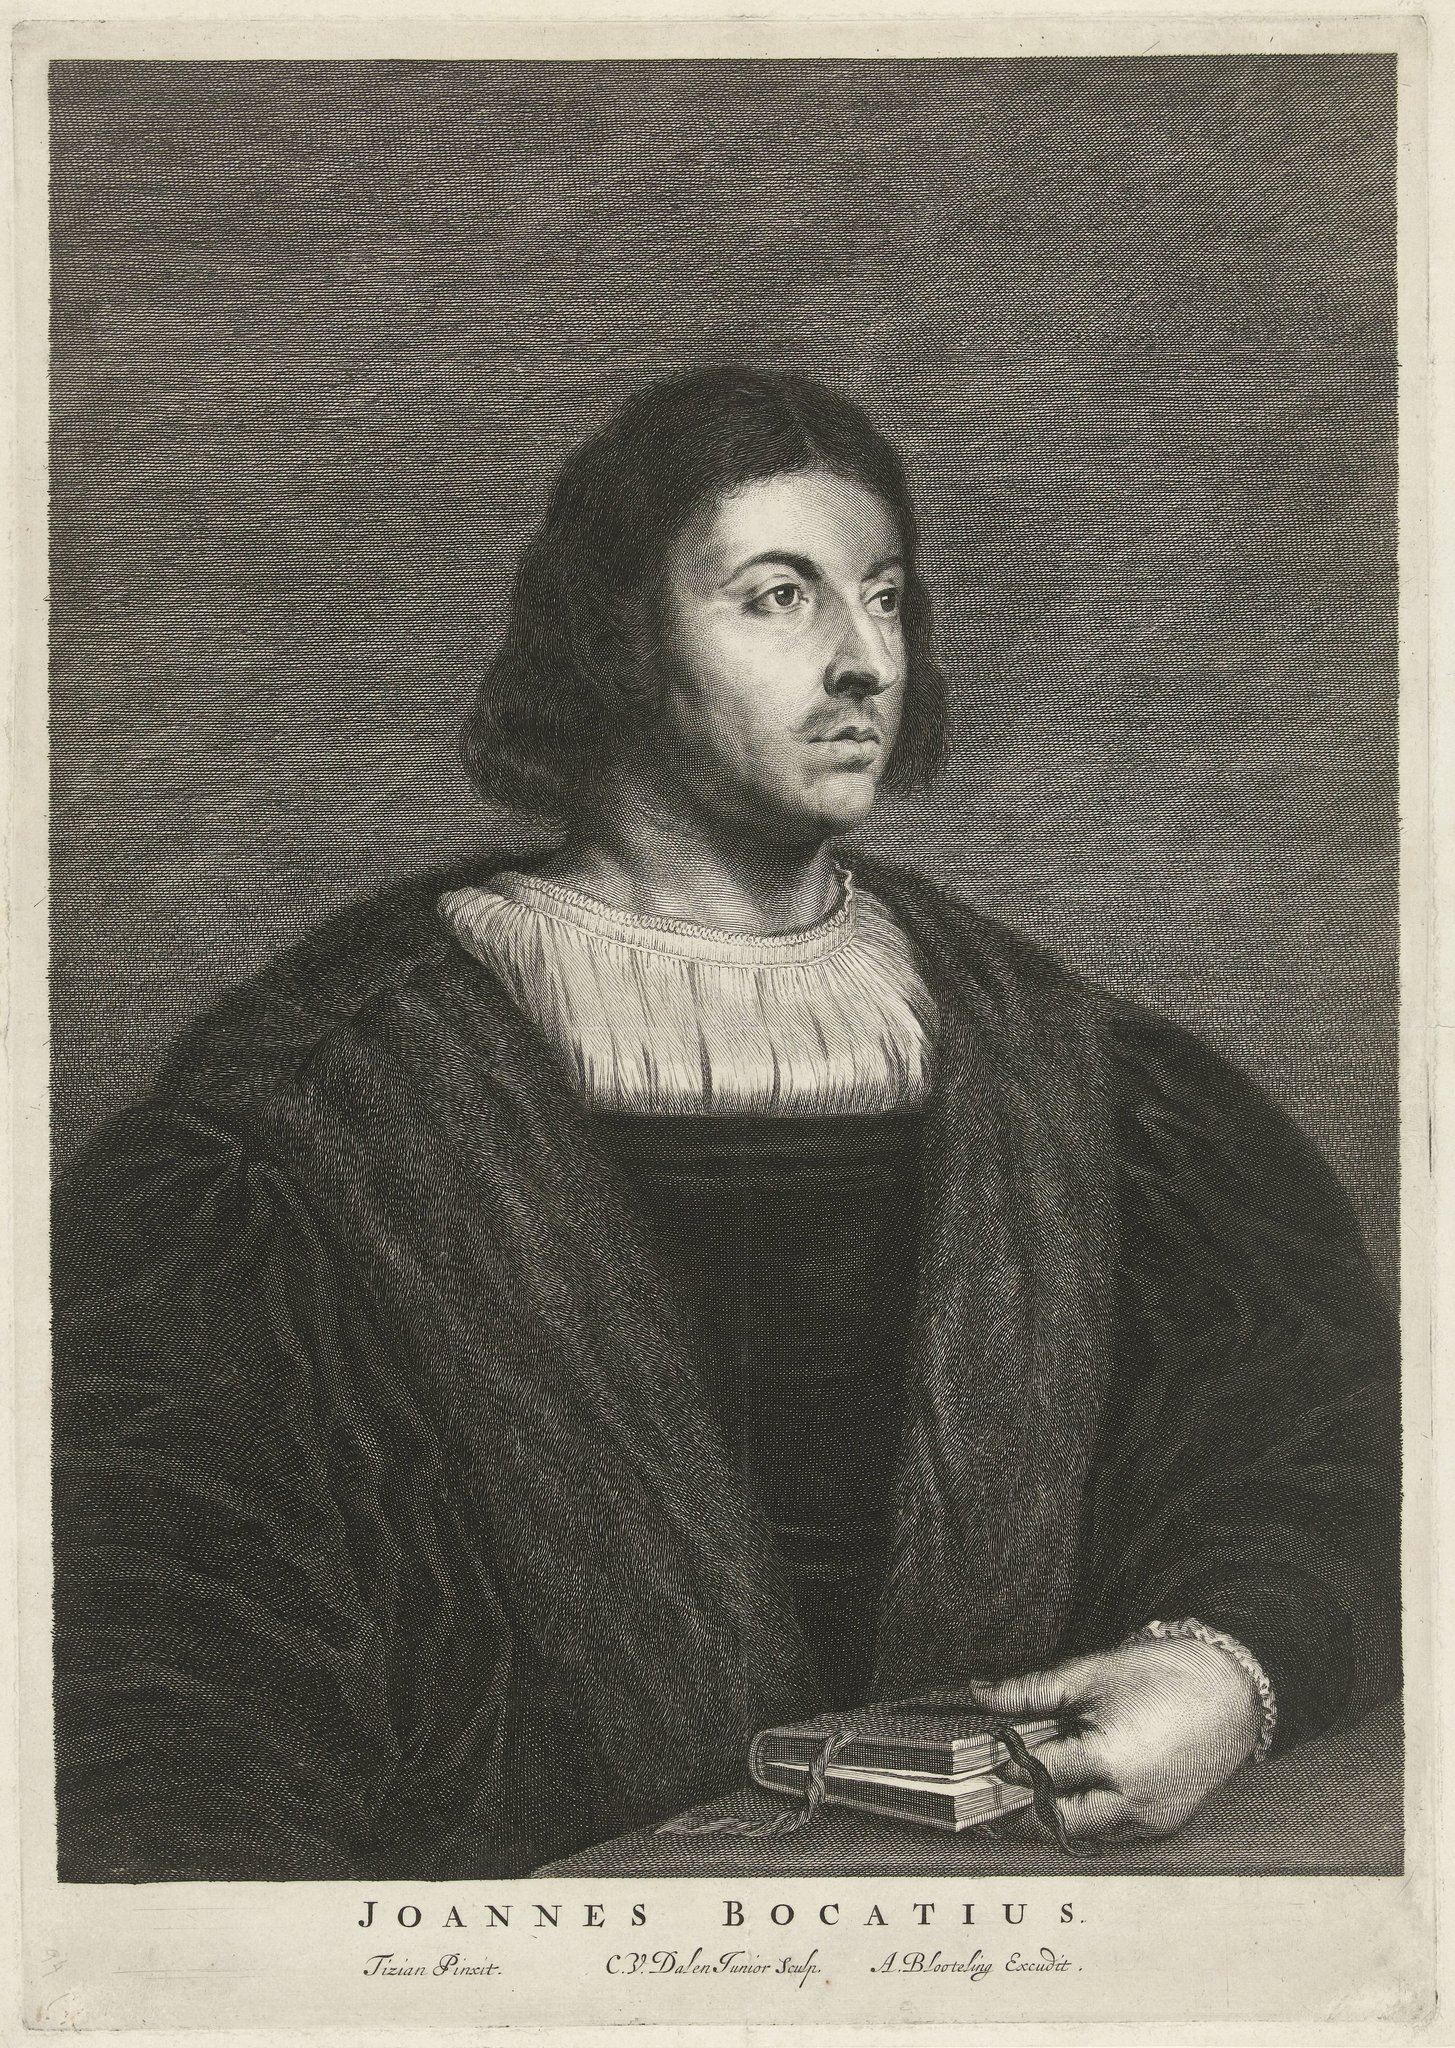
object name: print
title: Portret van Giovanni Boccacio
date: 1648-1664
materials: paper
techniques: engraving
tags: giovanni boccaccio, bard, lyric poet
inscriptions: collector's mark: Lugt 2228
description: Prent naar schilderij van Titiaan. Prent uit serie Caelaturae met vierendertig reprodukties naar Italiaanse en Nederlandse schilders, vervaardigd door de allerbeste graveurs in opdracht van de verzamelaar Gerard Reynst. Vergelijk het Reynst album uit de verzameling van Michiel Hinloopen met vier portretten door Cornelis van Dalen (II) in eerste staten in het Rijksmuseum, zie Waals 1988, p. 103, 104.